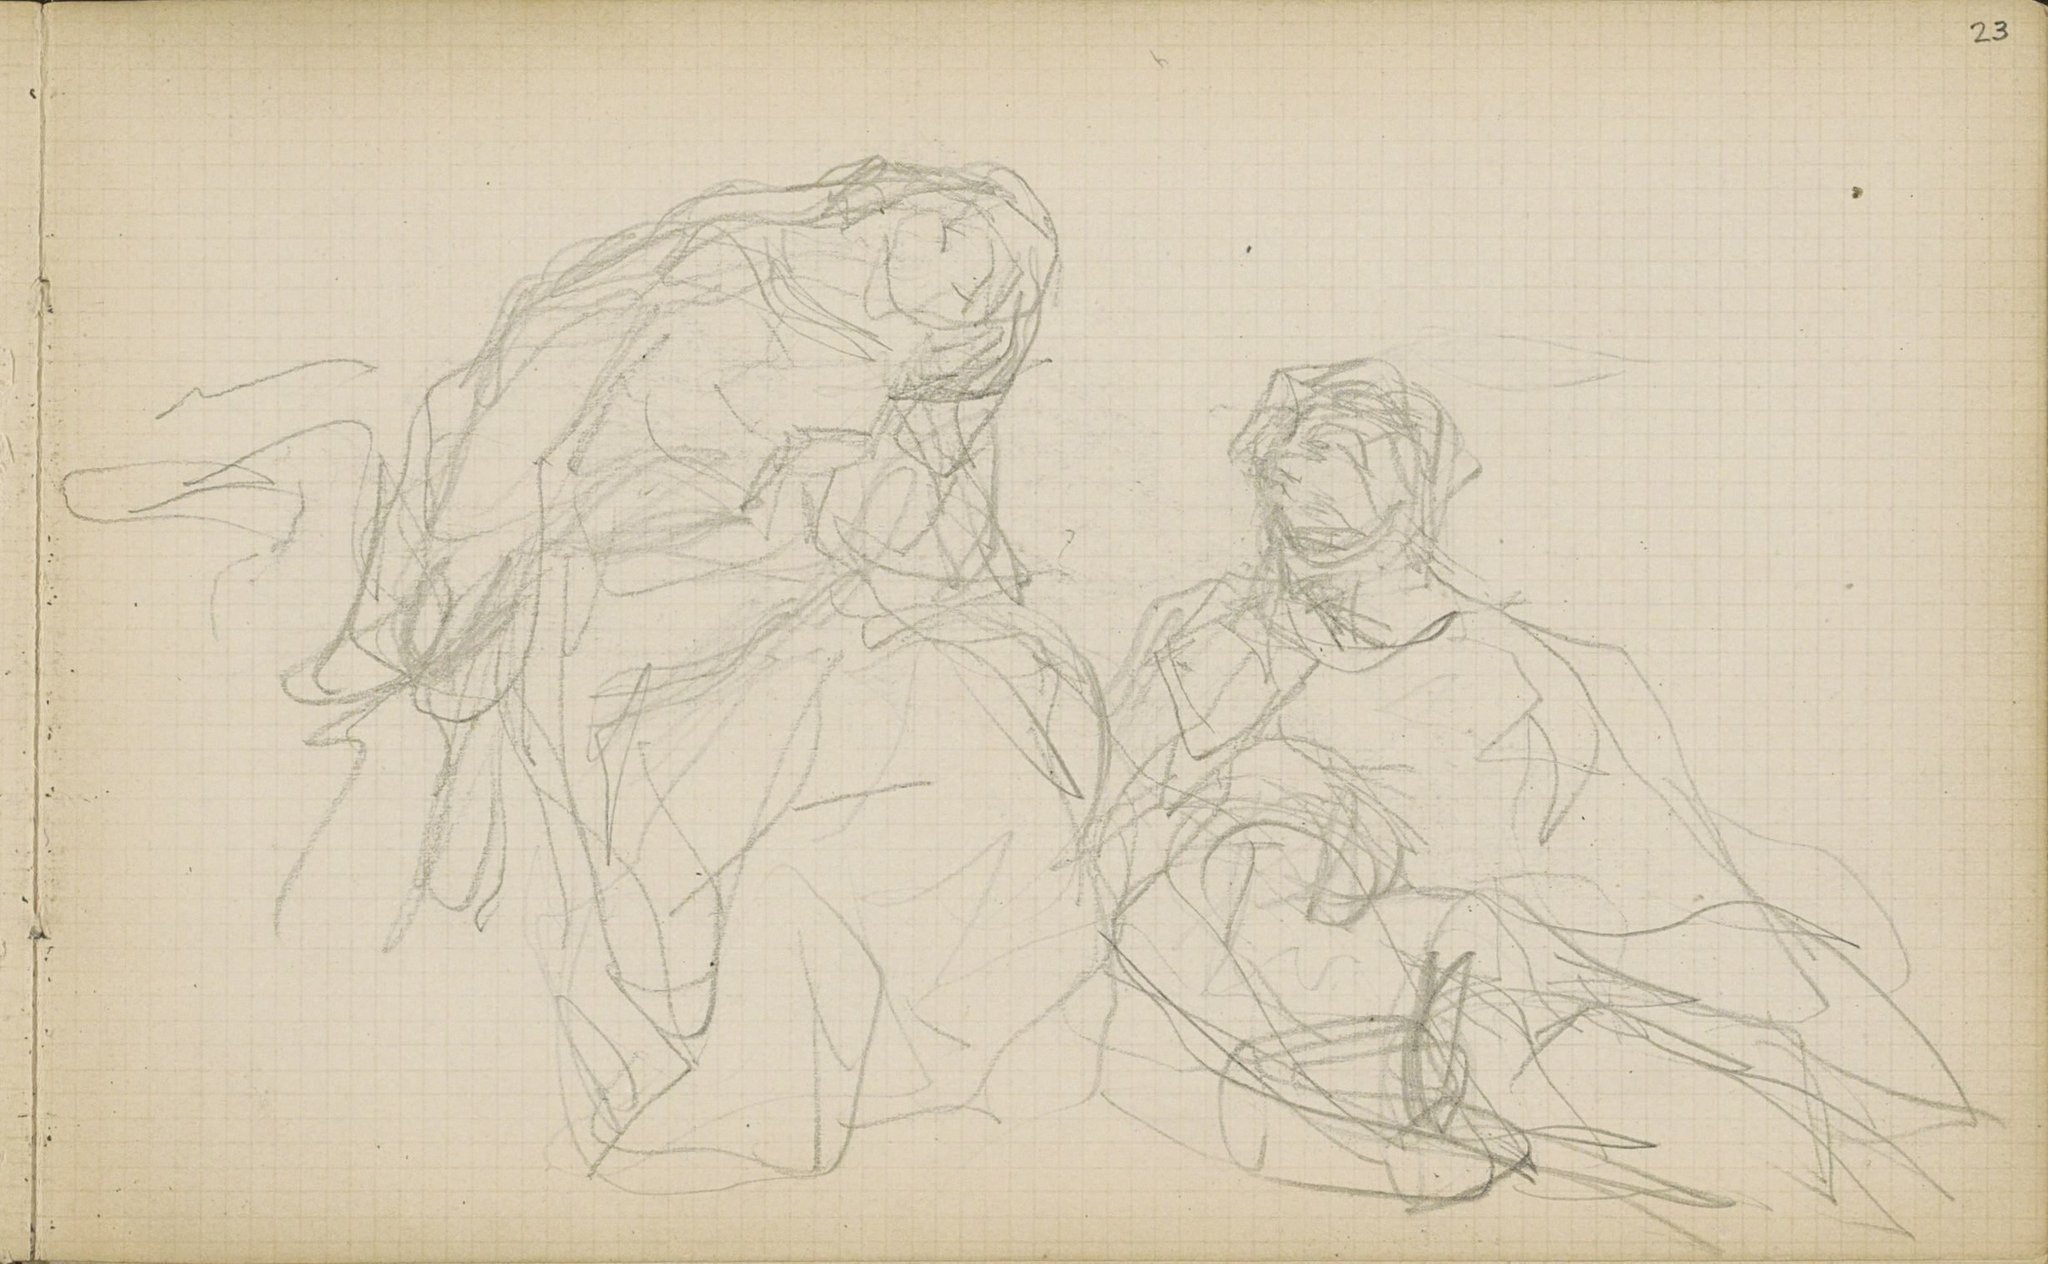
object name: sketchbook leaf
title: Zittende man en vrouw, de hoofden naar elkaar gewend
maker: matthijs maris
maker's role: draughtsman, painter, print maker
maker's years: 1839-1917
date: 1849-1917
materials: pencil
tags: sitting figure (+ female (human being) (not to be used where -aa- is prescribed)), sitting figure (+ male human being (not to be used where -a- is prescribed))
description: Blad 23 recto uit een schetsboek met 35 bladen.